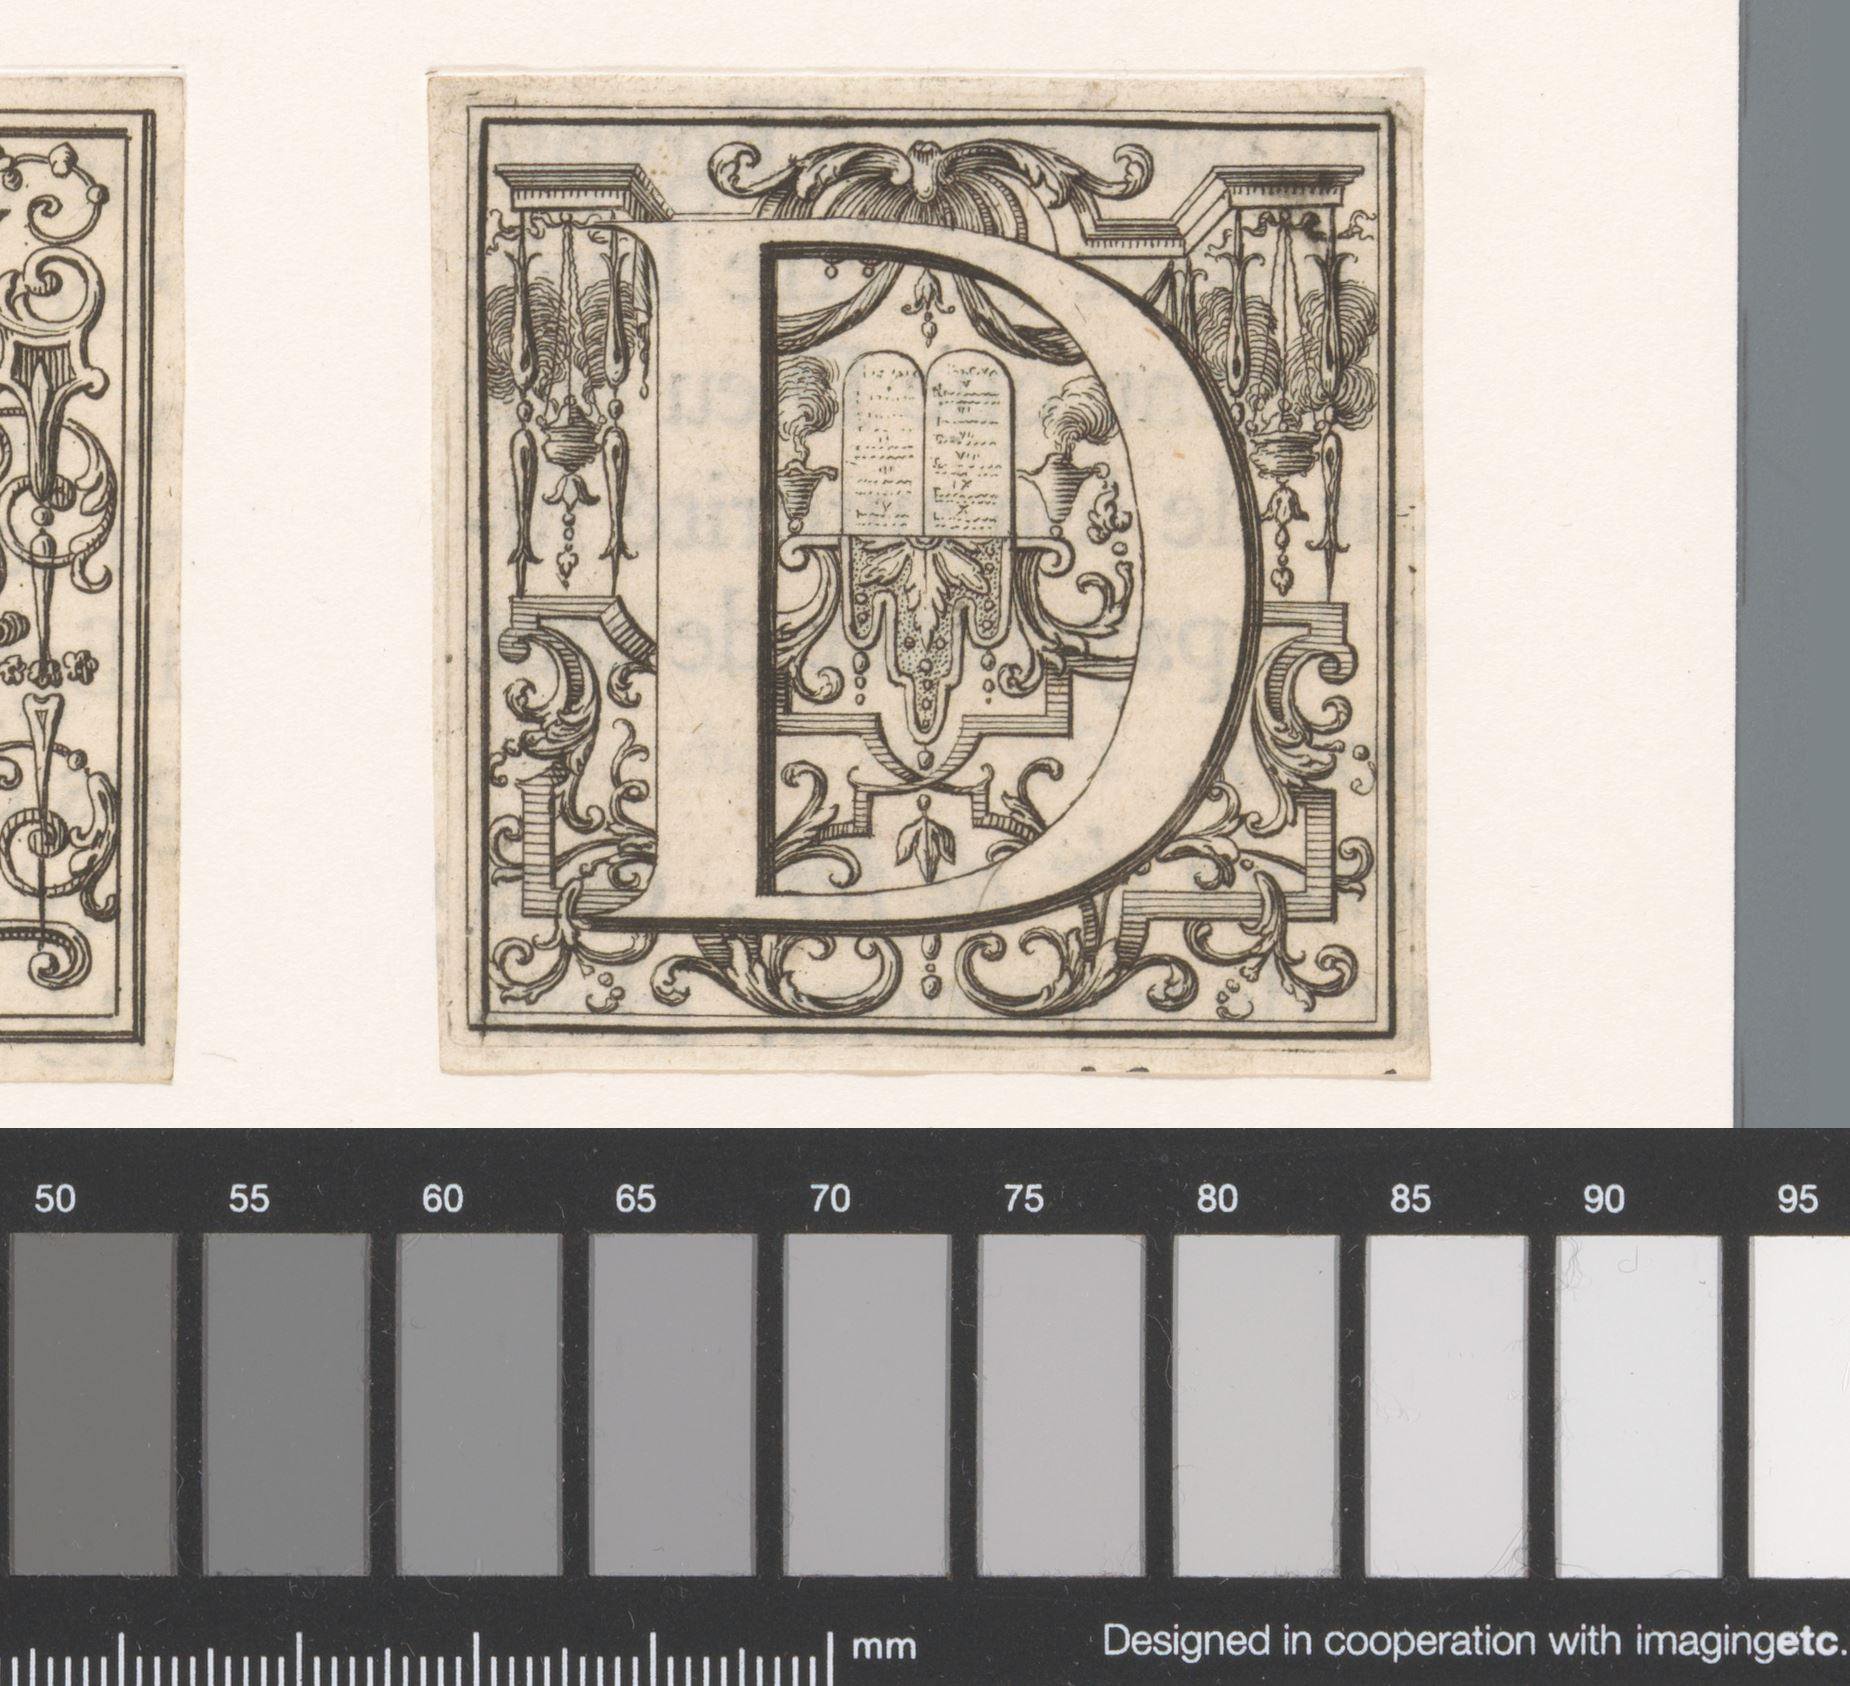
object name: print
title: Letter D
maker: Anonymous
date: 1700-1799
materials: paper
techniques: etching, letterpress printing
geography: france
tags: fancy letters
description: Letter D tegen een achtergrond met vlechtwerk en de stenen tafelen.